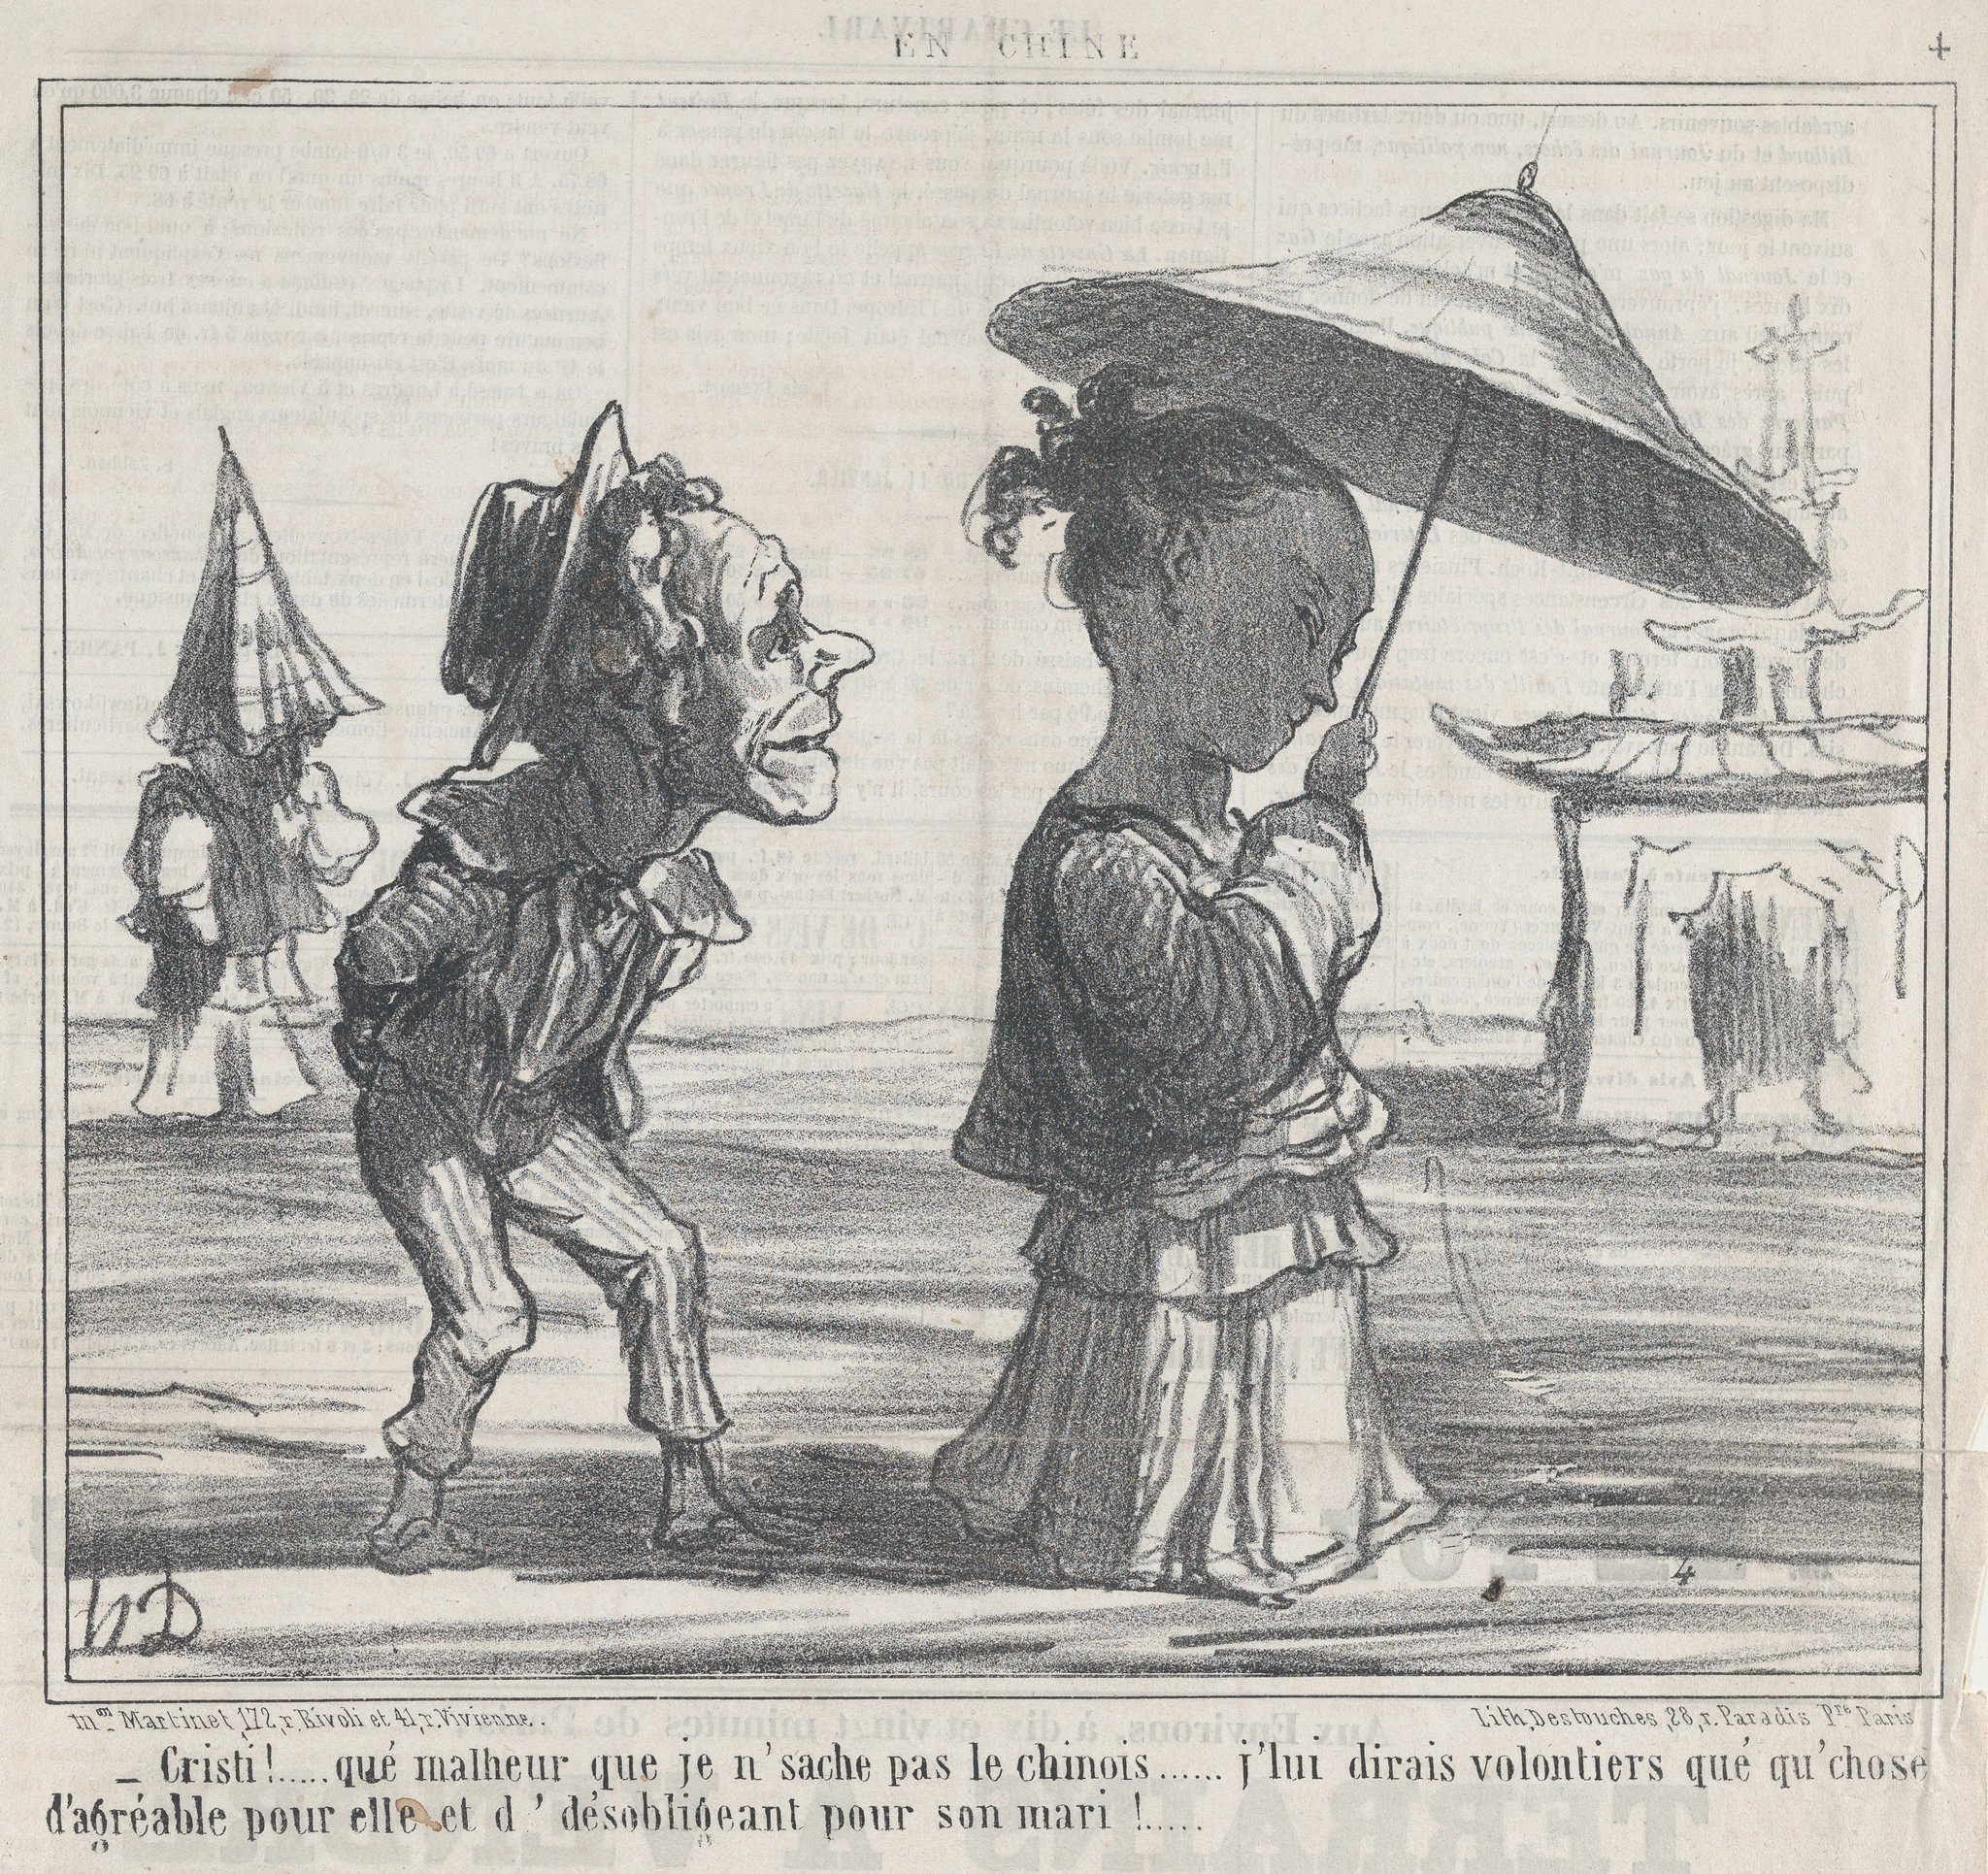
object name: print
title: Cristi! ..... qué malheur...., from En Chine, published in Le Charivari, January 12, 1859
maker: honoré daumier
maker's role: artist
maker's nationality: french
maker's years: 1808-1879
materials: paper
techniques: lithograph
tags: men,women,caricature,parasols